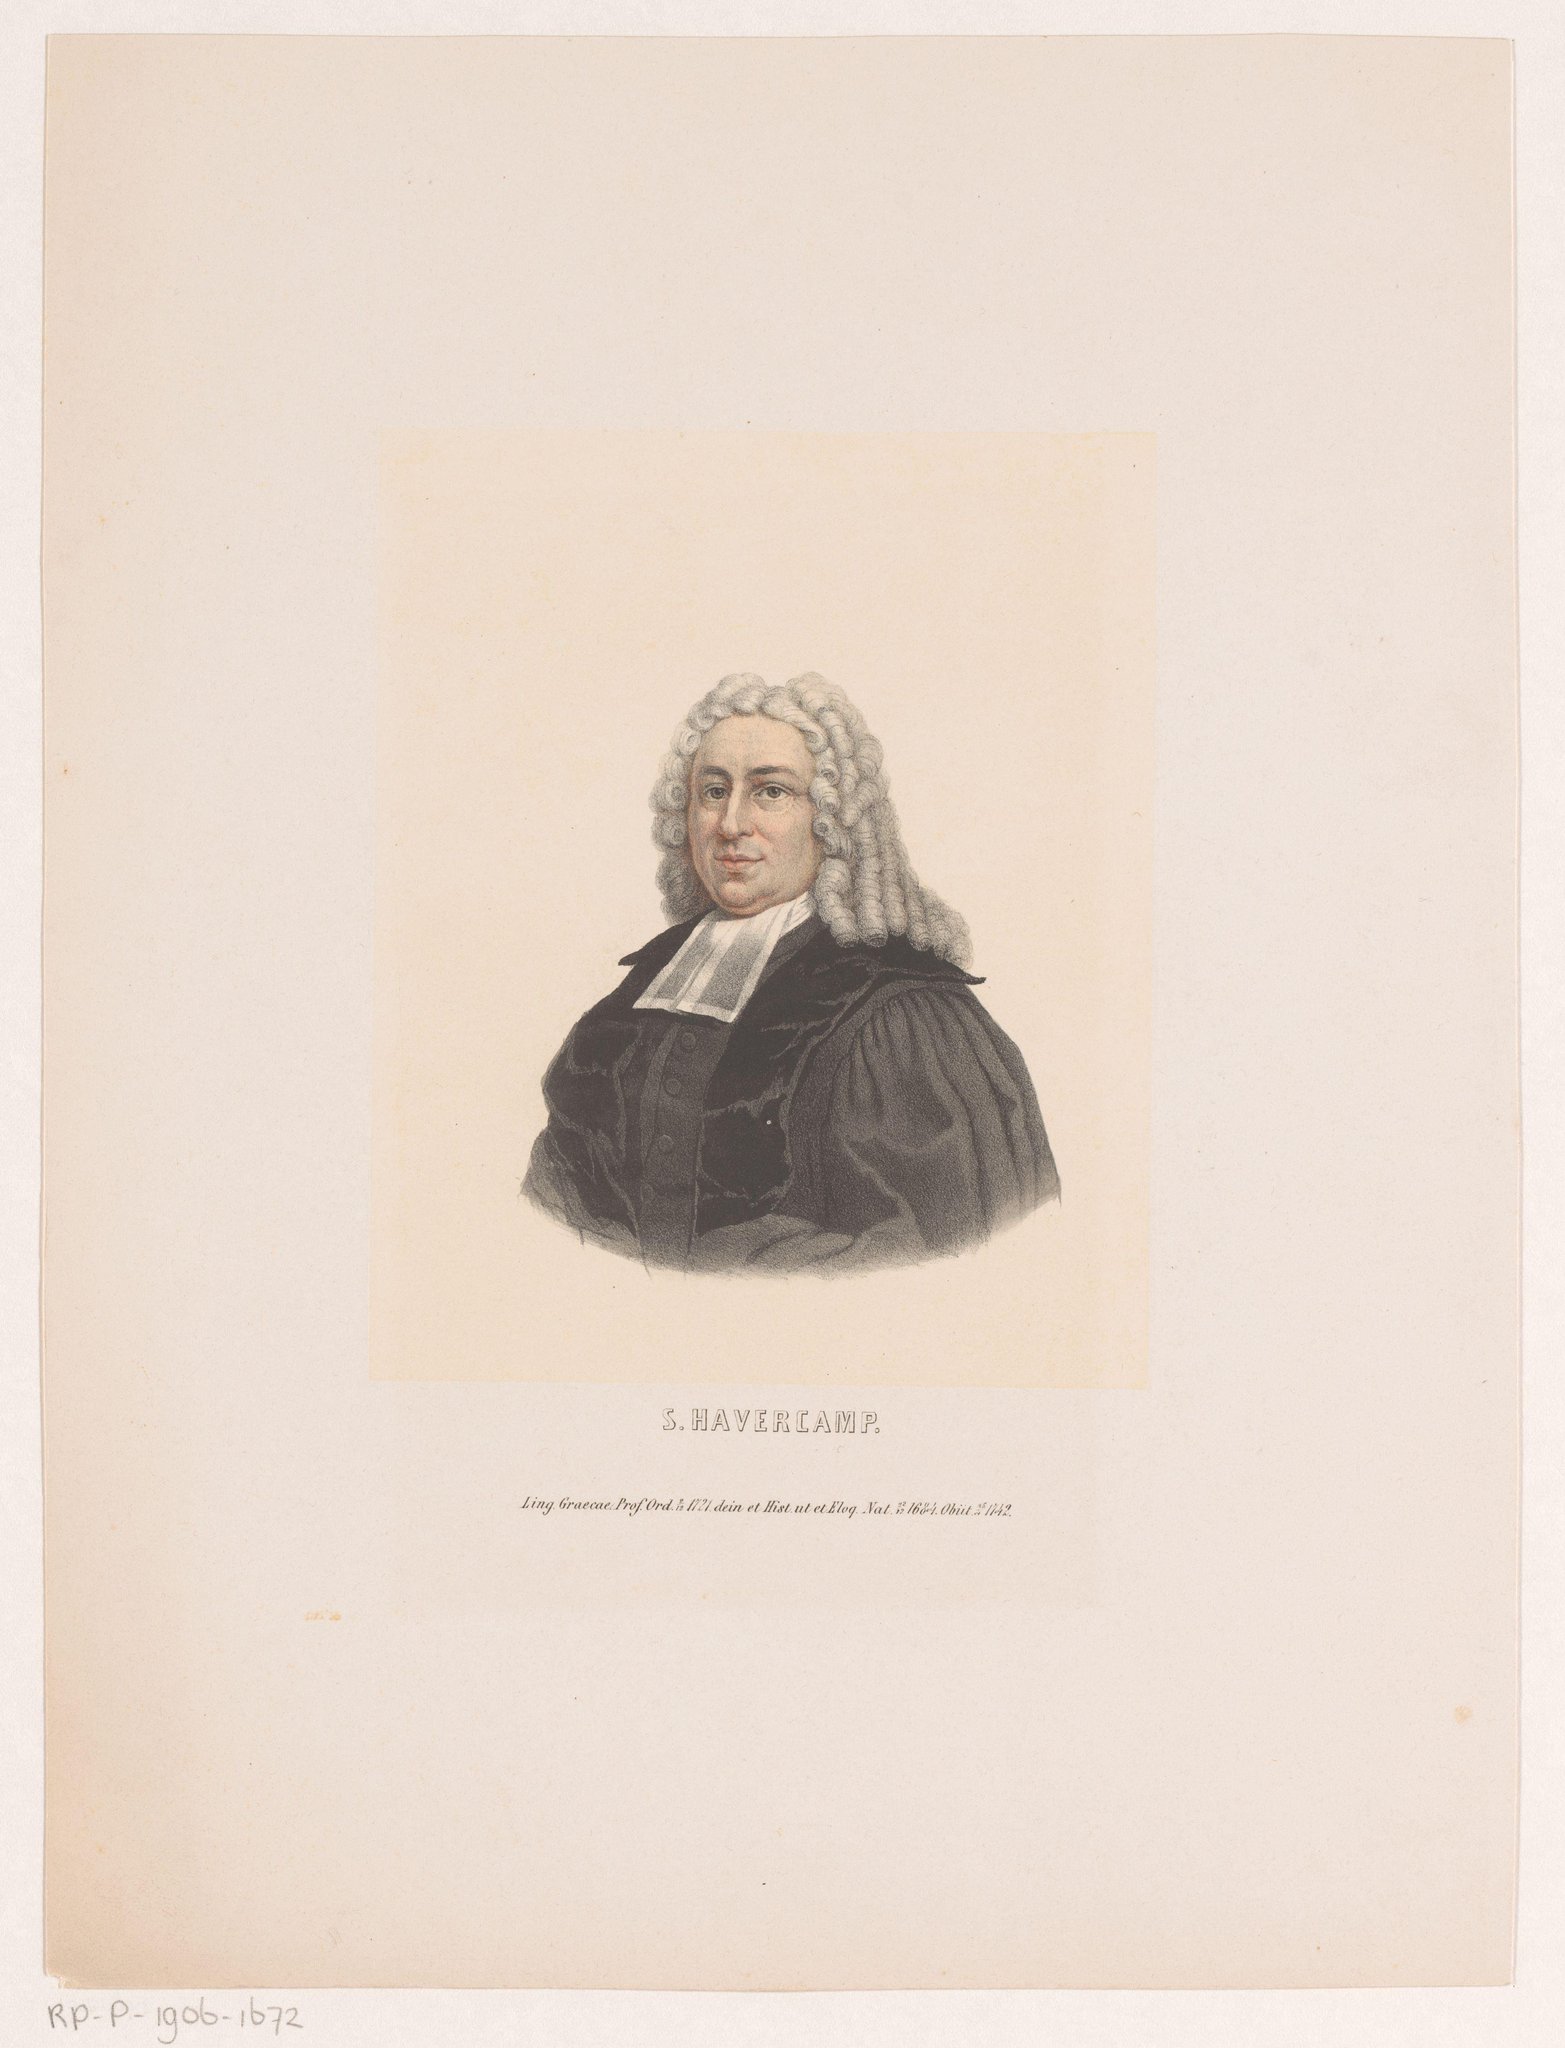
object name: print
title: S. Havercamp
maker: leendert springer (i)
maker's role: draughtsman, painter, print maker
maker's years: 1789-1871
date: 1850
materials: paper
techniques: lithograph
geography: leiden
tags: historical persons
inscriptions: collector's mark: Lugt 2228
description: Prent uit: Springer, Leendert. Galerij van hoogleeraren aan de Hoogeschool te Leijden, naar de oorspronkelijke afbeeldsels op de Senaat-zaal aldaar berustende. Leiden: Springer, Leendert., s.a. [circa 1850].